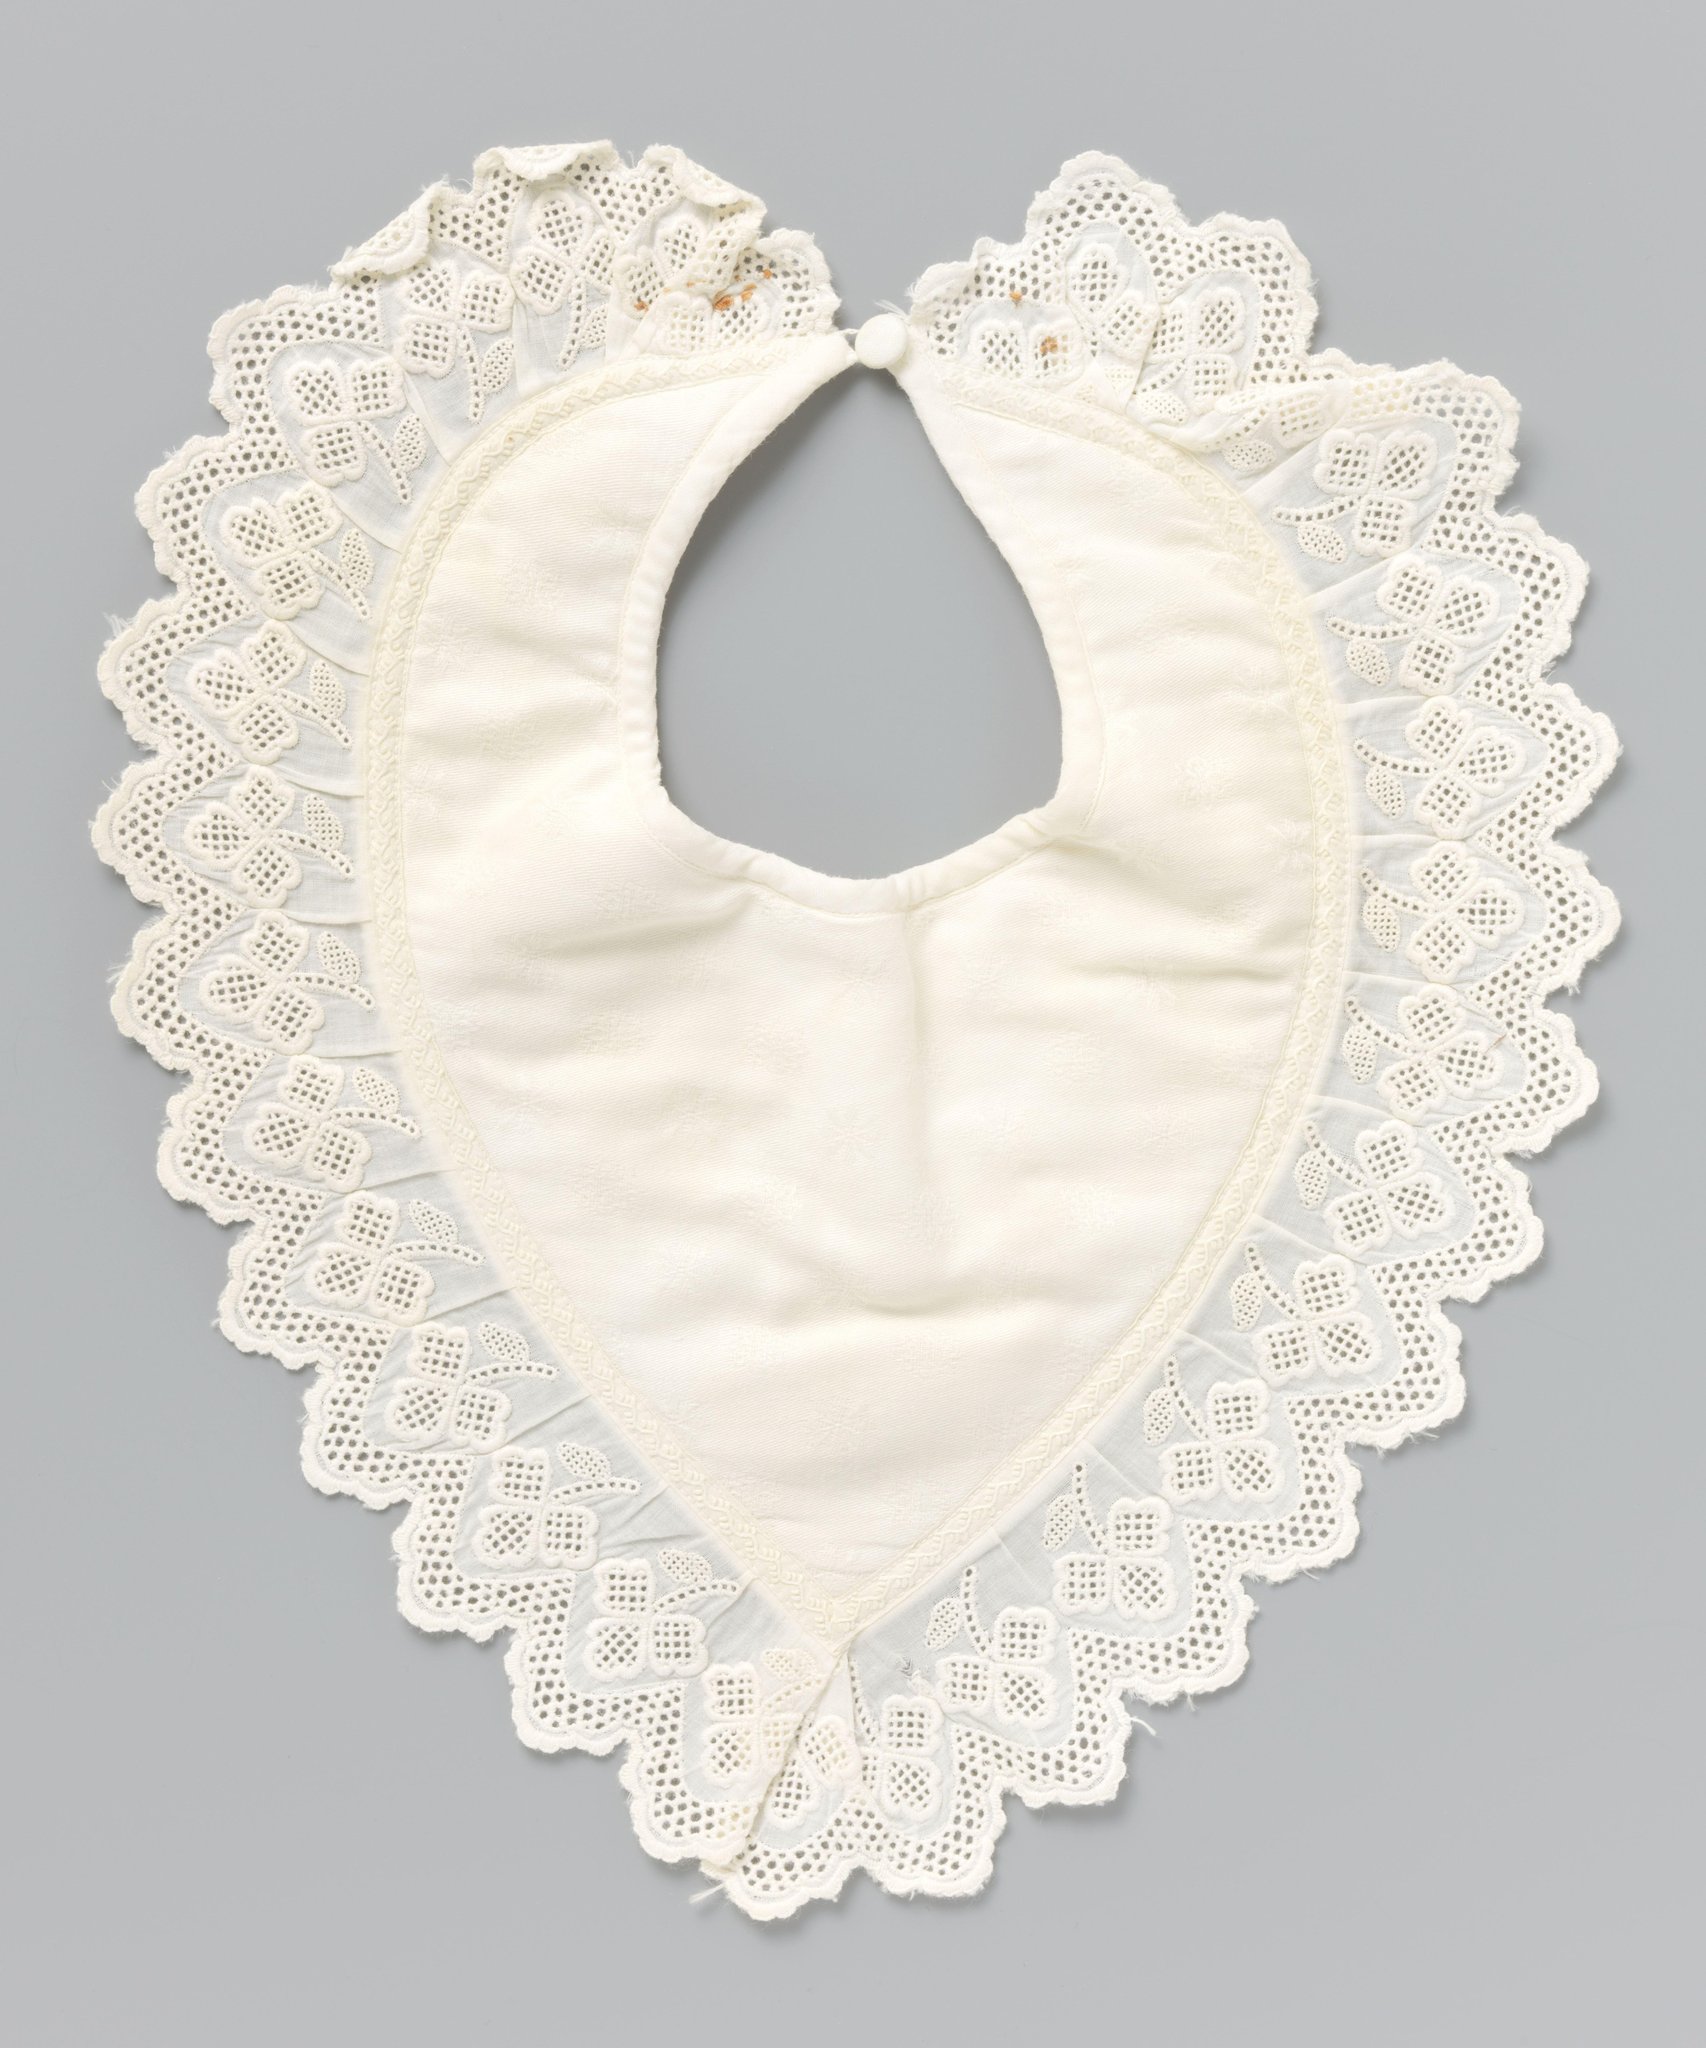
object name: childrenswear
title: Slab met puntvorm met ingeweven kristalvormig strooimotief, een wit geborduurde bladrank en afgezet met een geschulpte rand van Engels borduurwerk; flanellen onderlaag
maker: Anonymous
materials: textile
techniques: embroidered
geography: europe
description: Slab met puntvorm met ingeweven kristalvormig strooimotief, een wit geborduurde bladrank en afgezet met een geschulpte rand van Engels borduurwerk; flanellen onderlaag.